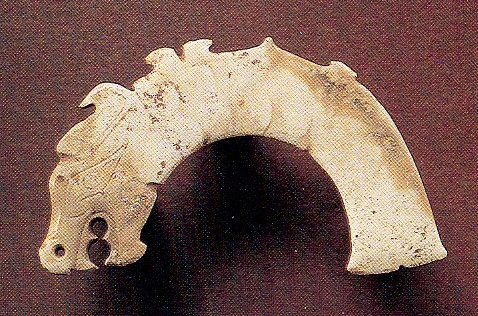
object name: pendant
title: Pendant in the shape of an animal with fish tail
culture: chinese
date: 1100-901 BCE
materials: jade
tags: animals